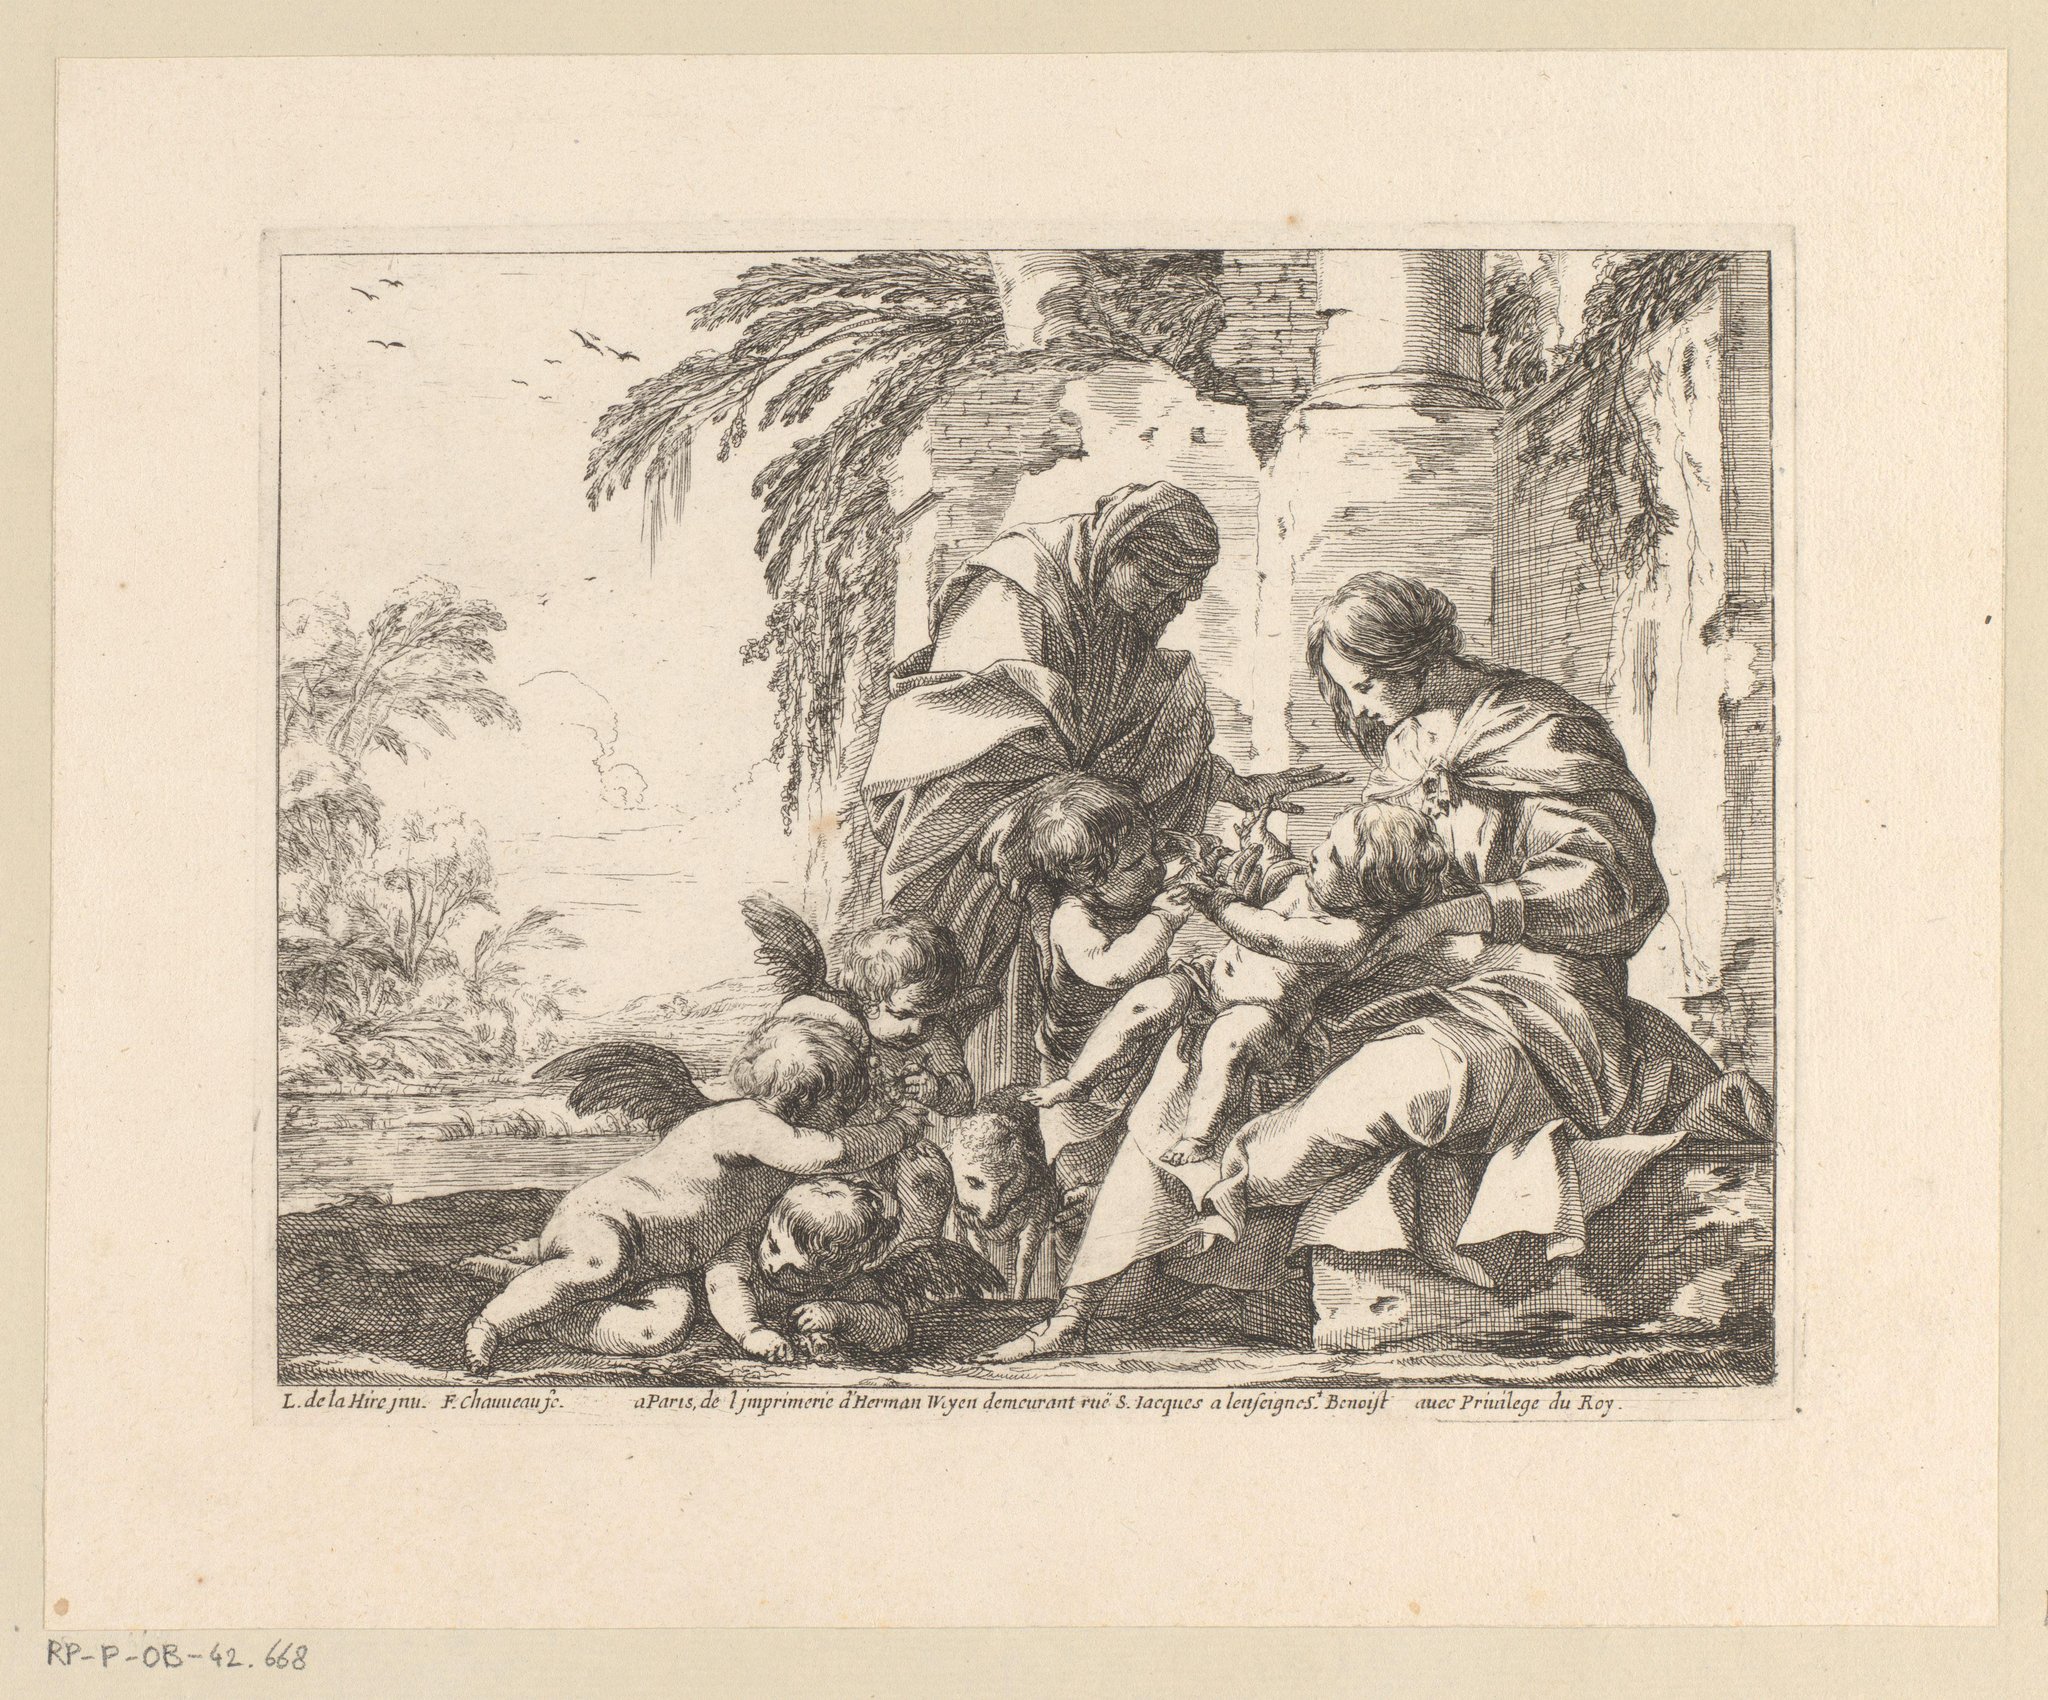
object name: print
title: Maria met Kind, Johannes de Doper, Elisabeth en engelen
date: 1623-1672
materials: paper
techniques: etching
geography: paris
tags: mary, the christ-child and john the baptist, elisabeth present, cupids: 'amores', 'amoretti', 'putti'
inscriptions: collector's mark: Lugt 240